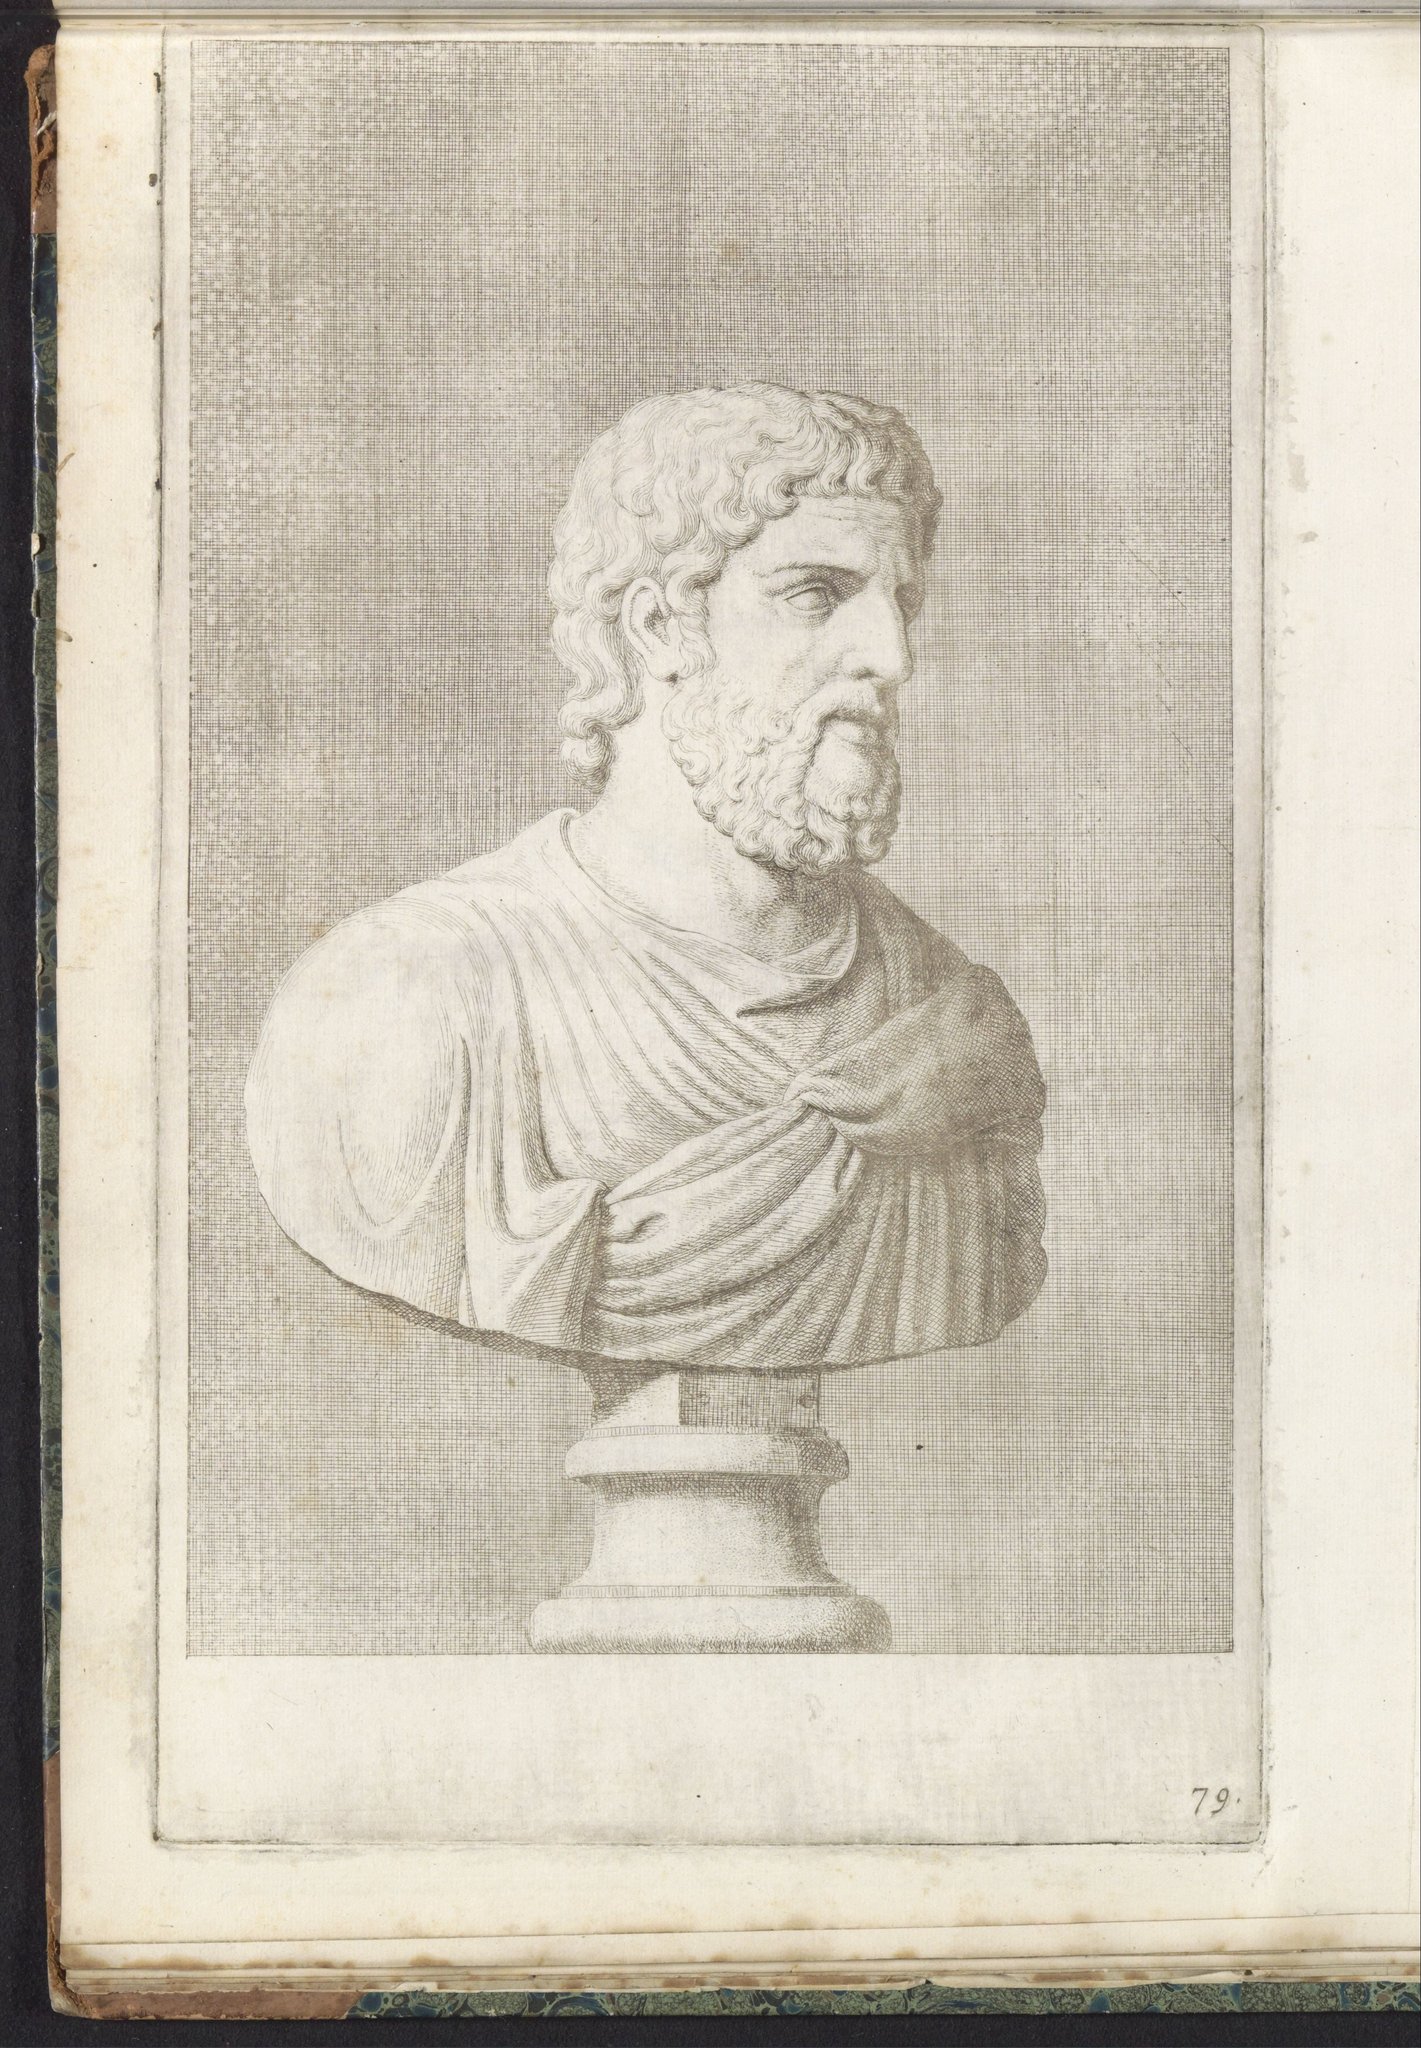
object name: album leaf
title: Buste van een bebaarde man, naar rechts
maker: hubert quellinus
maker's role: print maker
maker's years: 1619-1687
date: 1646-1670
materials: paper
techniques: engraving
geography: antwerp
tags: piece of sculpture, reproduction of a piece of sculpture, male persons from classical history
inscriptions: number: ‘79’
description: De prent maakt deel uit van een album met een serie prenten naar de sculpturen in de verzameling van Gerard Reynst.